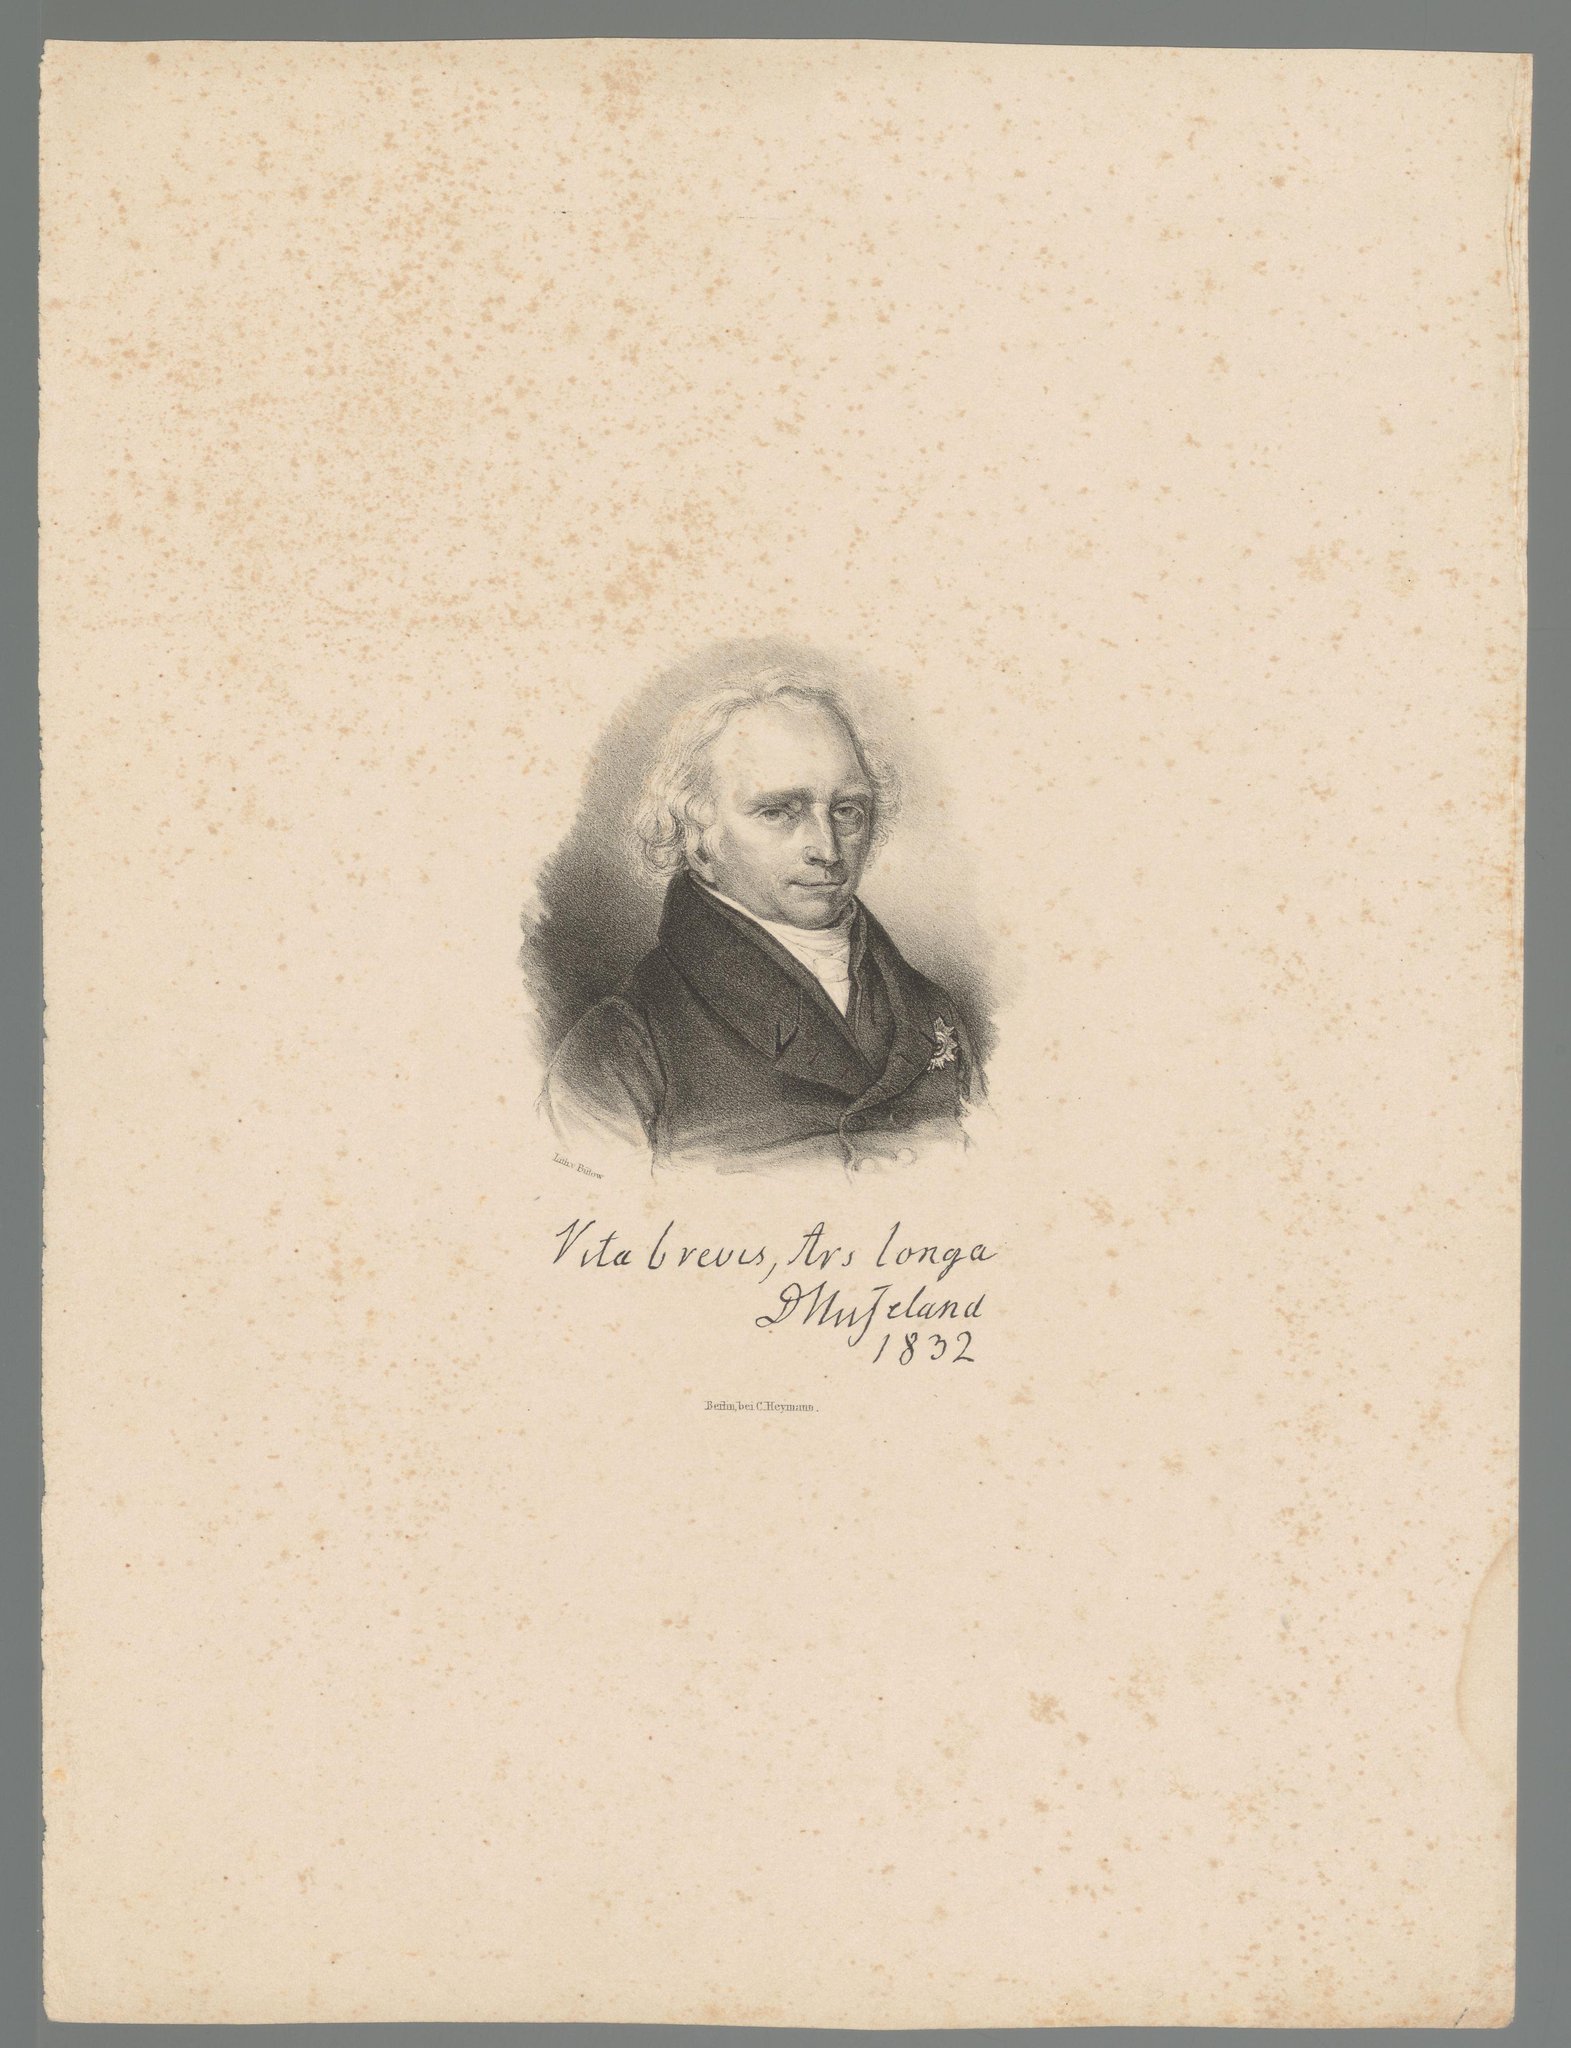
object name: print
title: Portret van Christoph Wilhelm von Hufeland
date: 1832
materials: paper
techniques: lithograph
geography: berlin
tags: berlin, adult man, historical persons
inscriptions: collector's mark: Lugt 2228